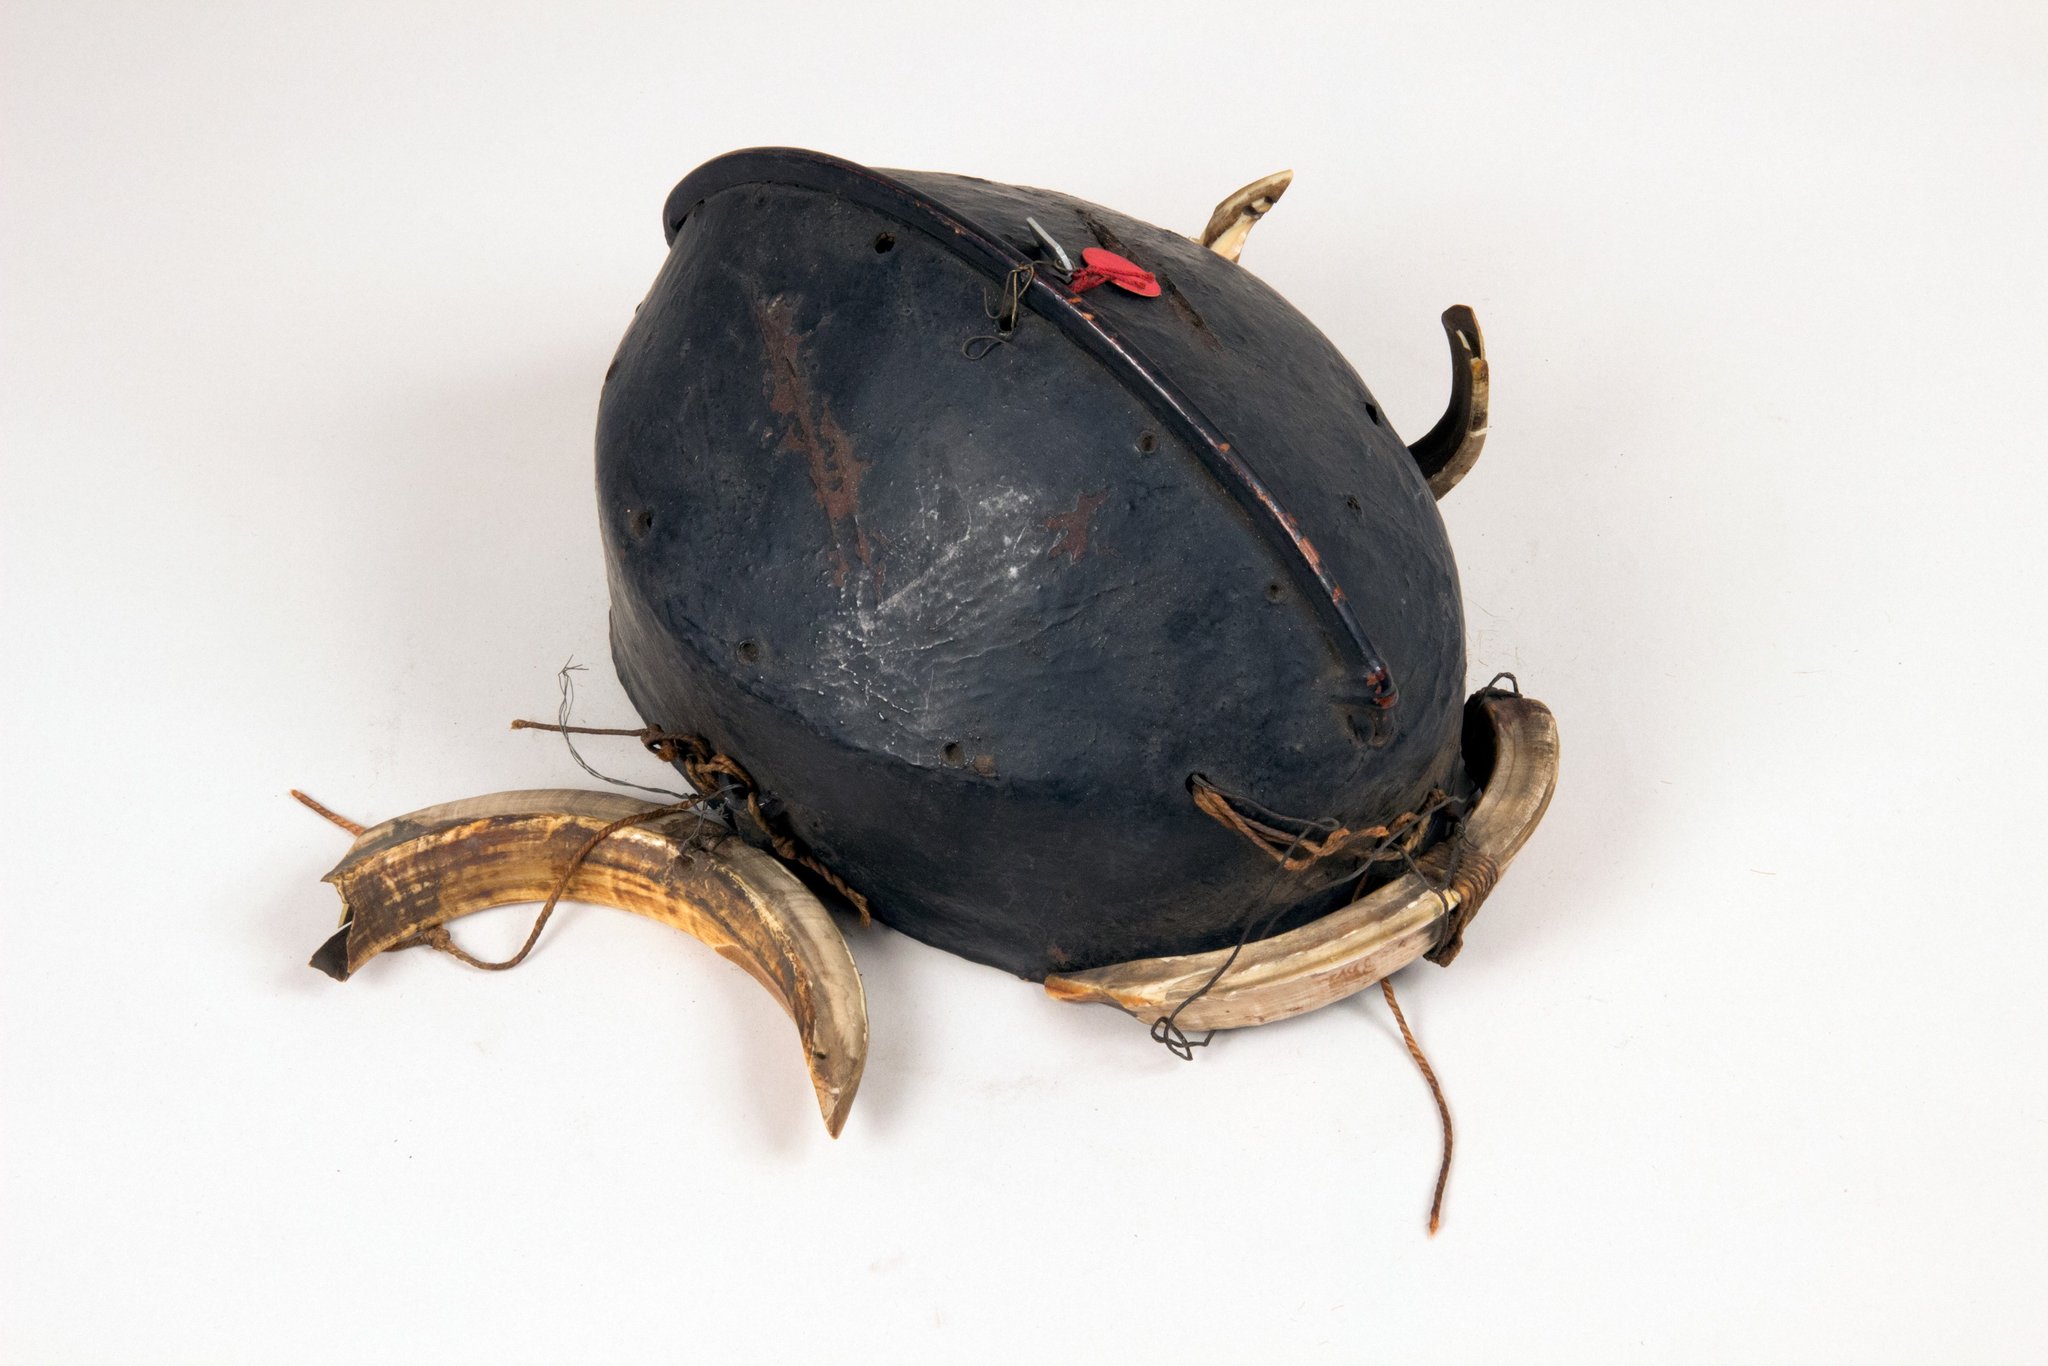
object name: helmet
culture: singpho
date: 1801-1900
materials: ivory, lacquer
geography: burma